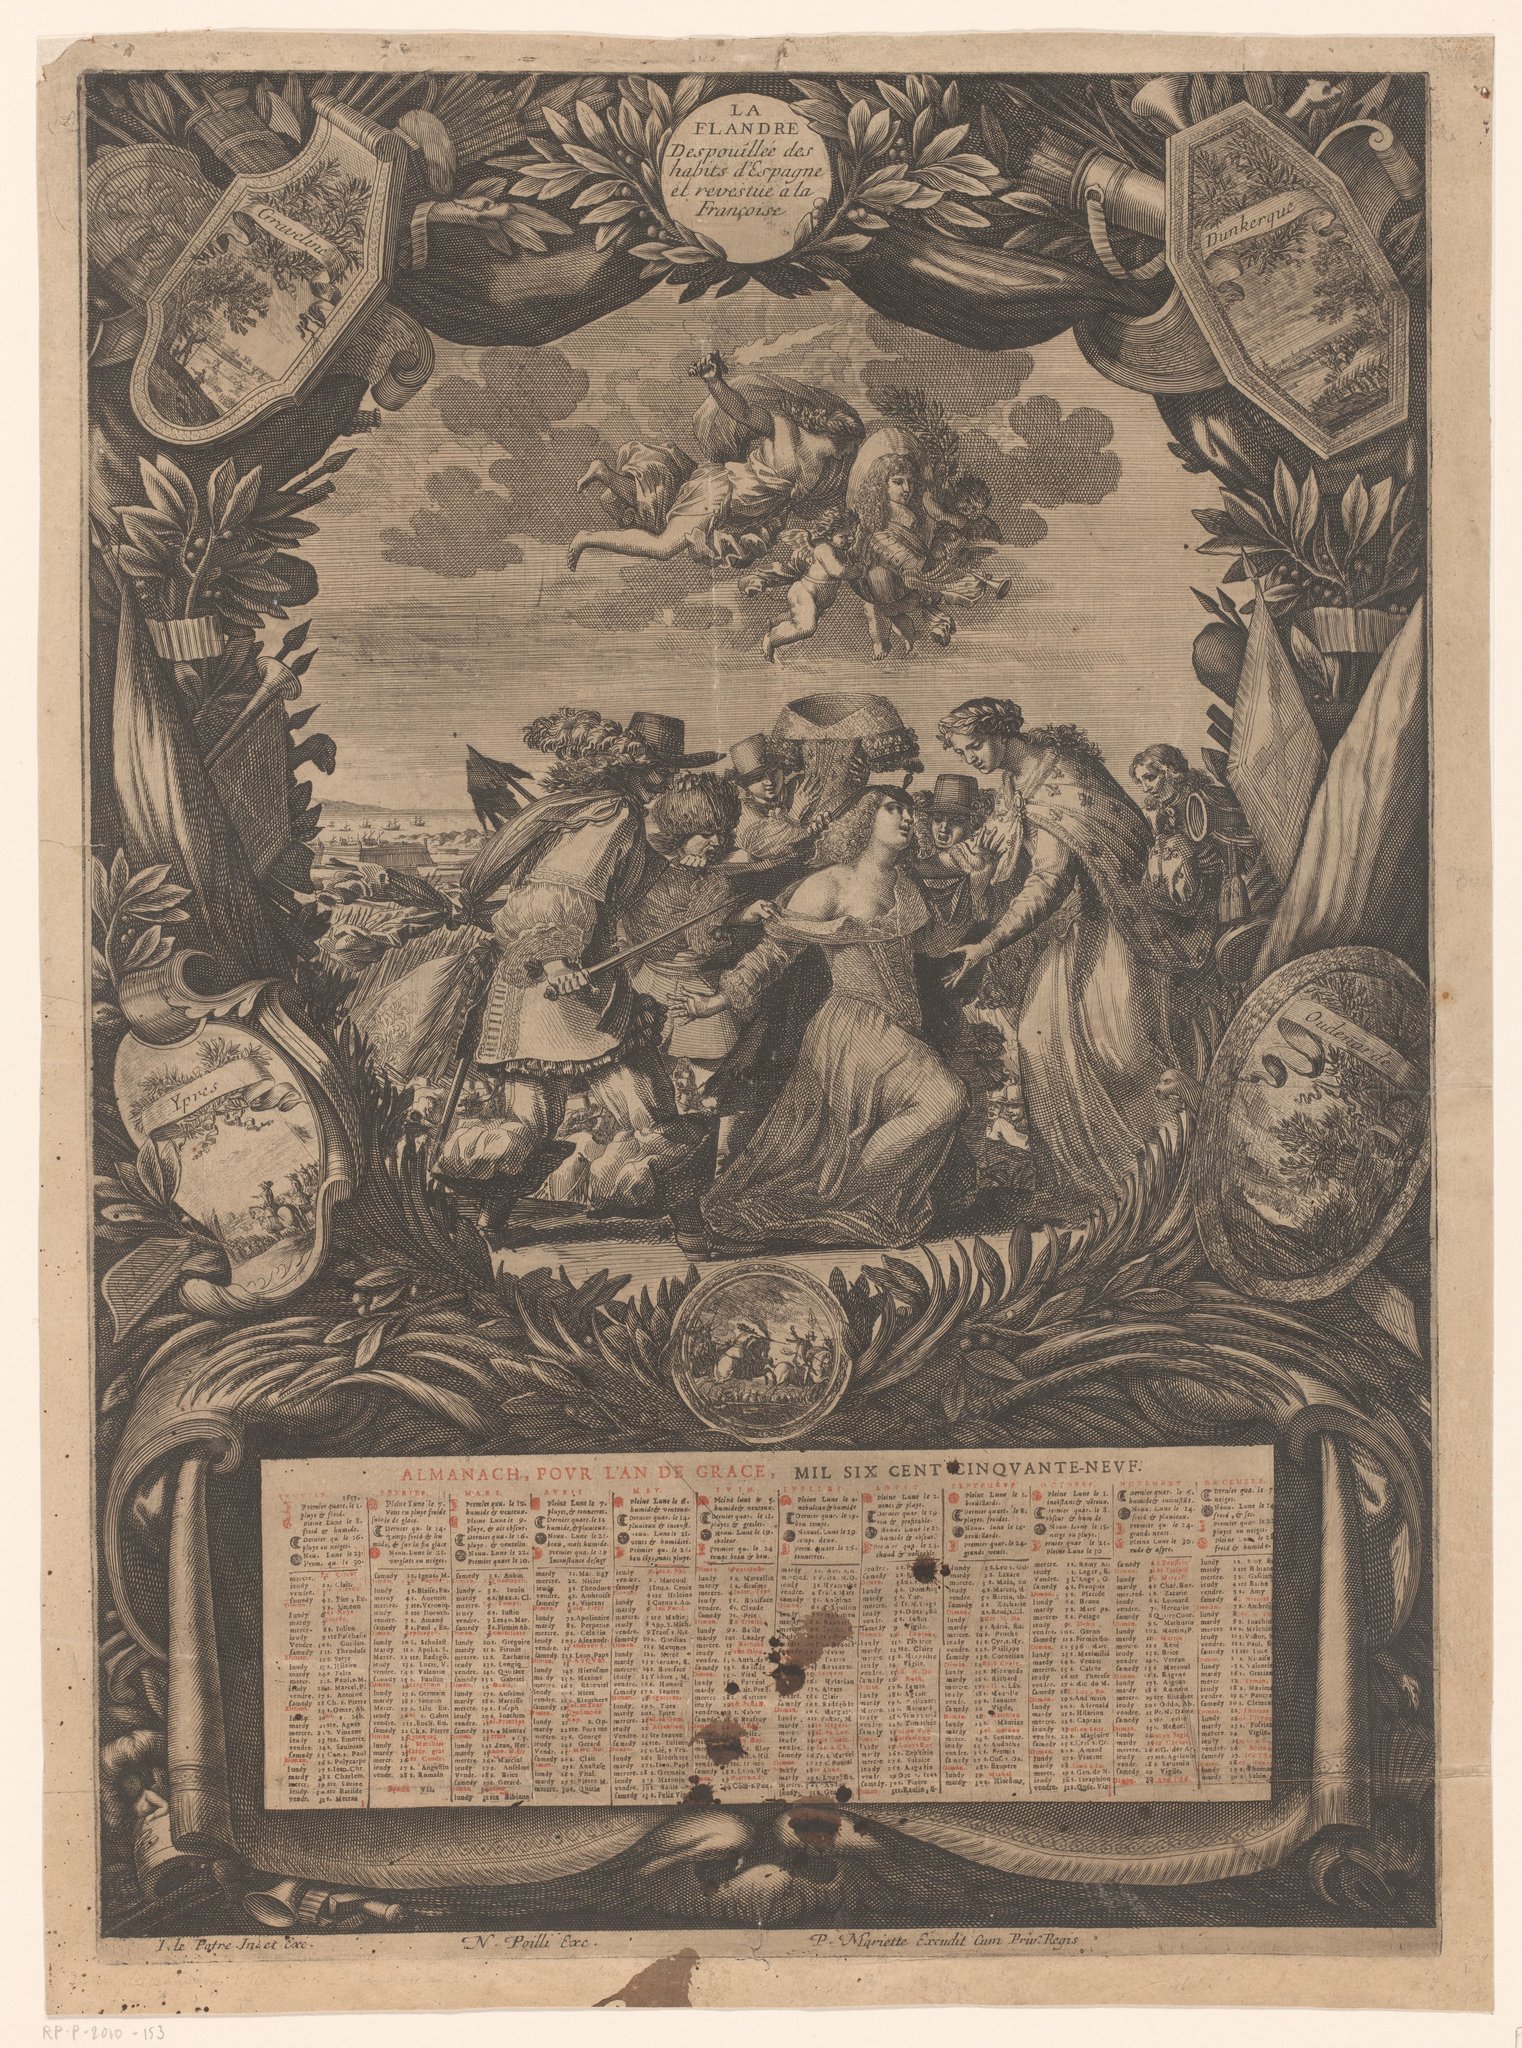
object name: print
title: Calender for 1659: Allegory on the Submission of Flanders to Louis XIV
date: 1659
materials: paper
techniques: engraving, etching, letterpress printing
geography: france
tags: lodewijk xiv (koning van frankrijk), personifications of countries, nations, states, districts, etc., dress, gown, surrender ~ war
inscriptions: collector's mark: Lugt 2760, collector's mark: Lugt 2228, inscription: ‘La Flandre/ Despouillé des/ habits d'Espagne/ et revestue à la/ Françoise’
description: The war between France and Spain, which had lasted 24 years, came to an end in 1659. The defeated Spanish king, Philip IV, was forced to cede large parts of the southern Netherlands to the French king, Louis XIV. Here the figure of France (wearing a cloak decorated with fleurs-de-lis) strips Flanders of her Spanish costume and dresses her in the latest French fashion.